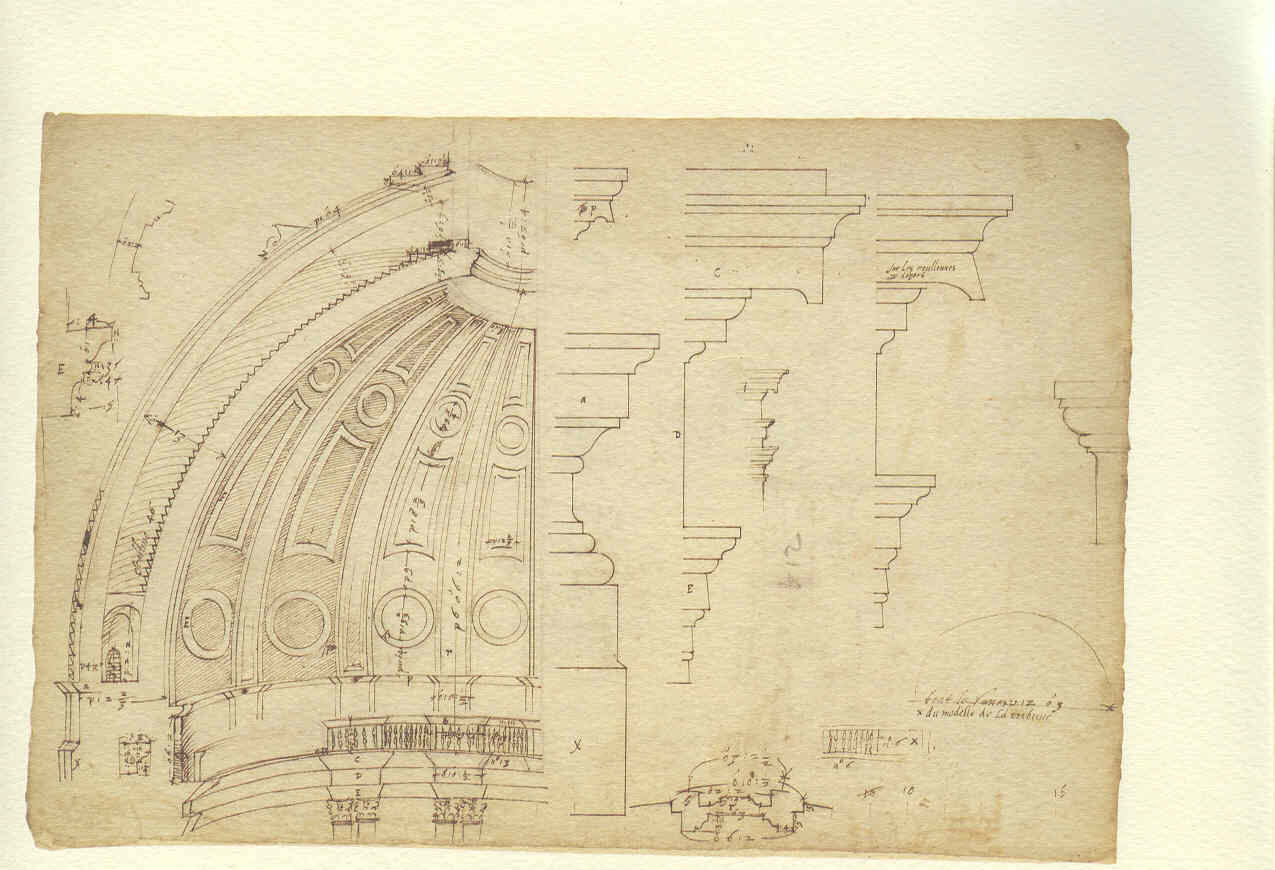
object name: drawing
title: Half-Section of the Model of the Attic and Dome of Saint Peter's Basilica as Conceived by Michelangelo (recto); Detail Studies Relating to the Plan, Section, and Elevation of the Dome of Saint Peter's Basilica (verso).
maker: etienne dupérac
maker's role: artist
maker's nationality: french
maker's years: 1535-1604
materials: chalk, ink, drawing material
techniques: pen